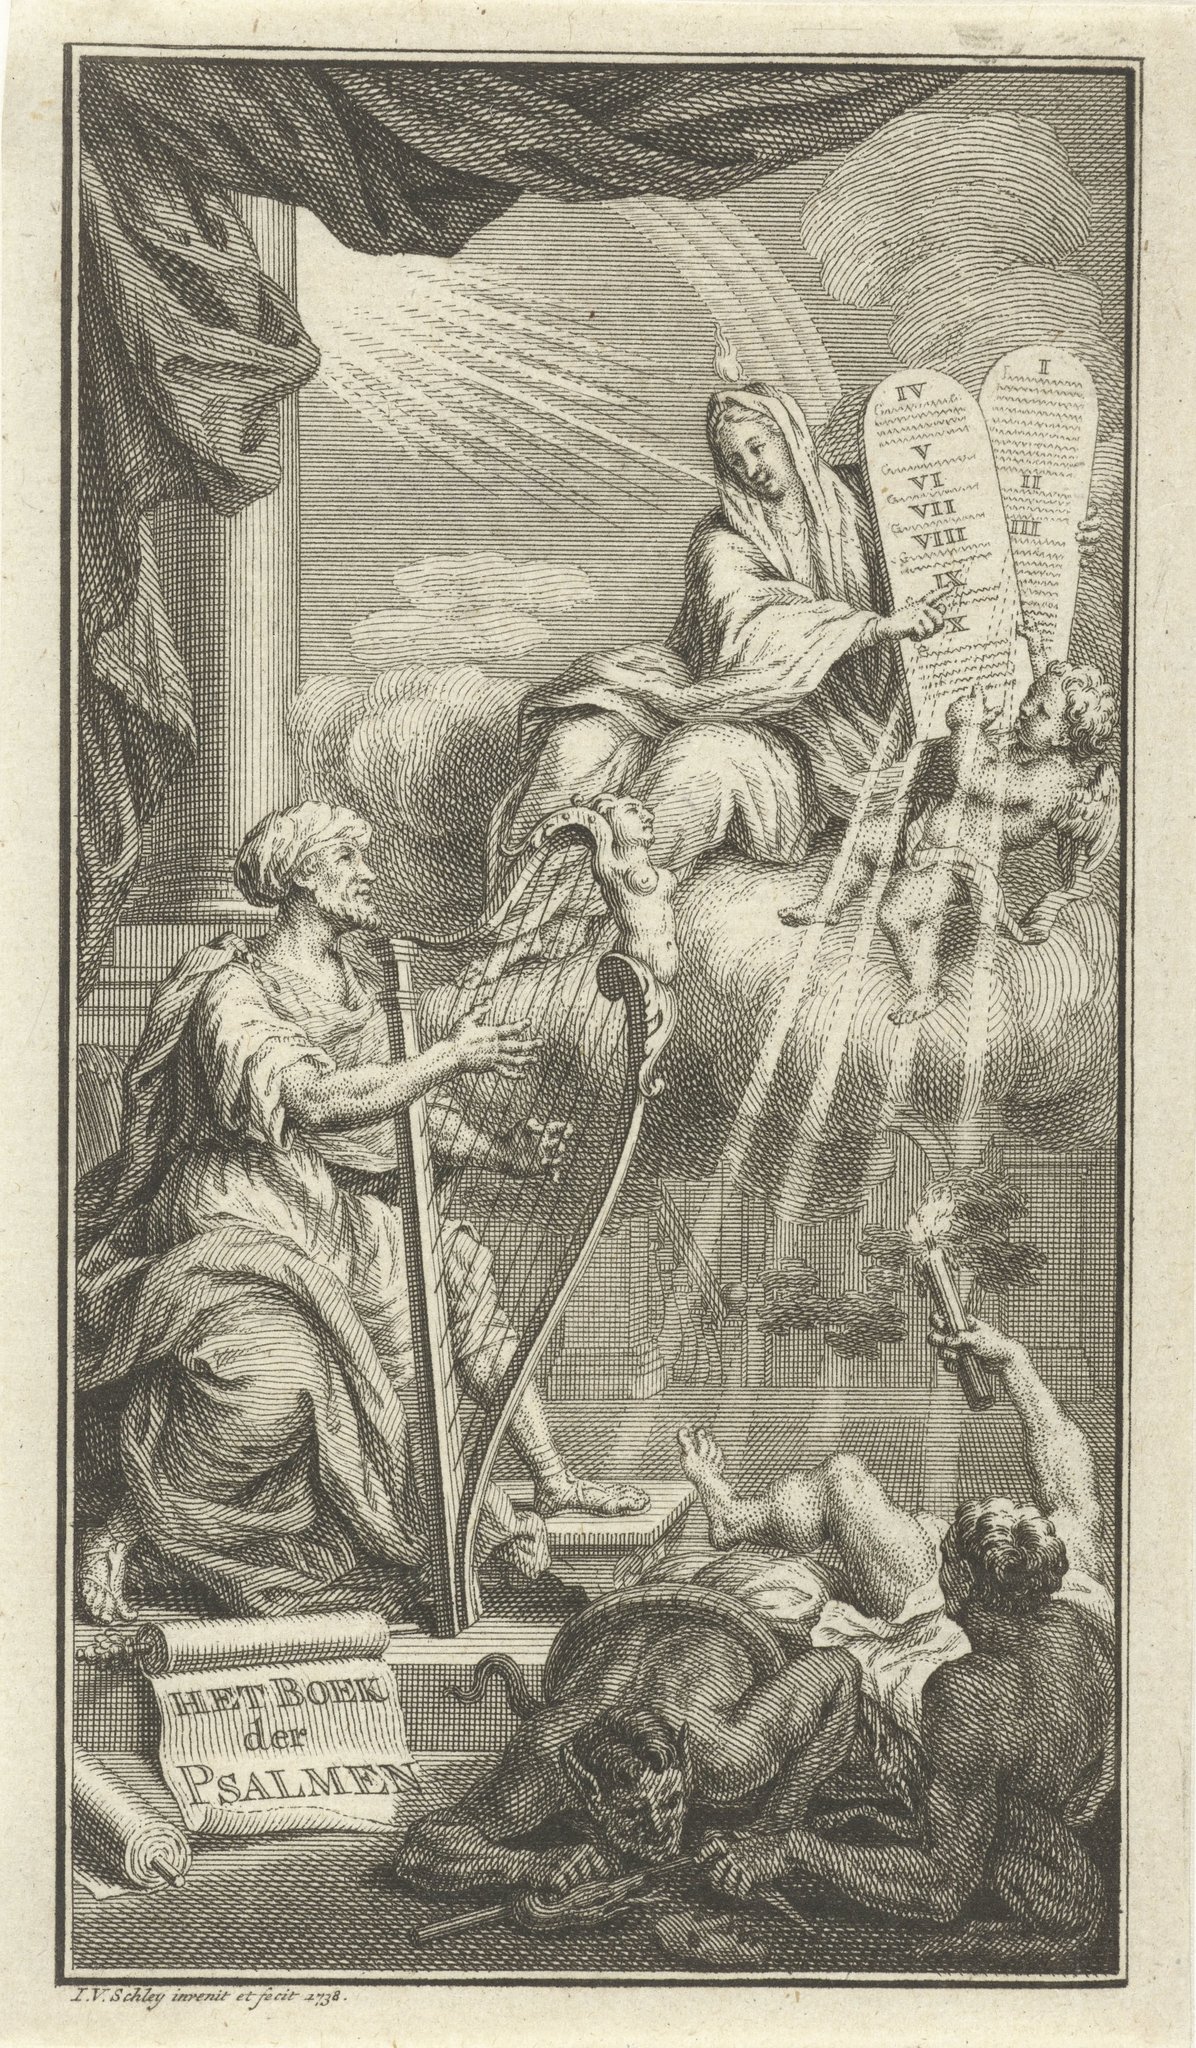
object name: print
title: Titelprent voor, Het Boek der Psalmen, 1738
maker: jacob van der schley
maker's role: draughtsman, print maker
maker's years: 1715-1779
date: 1738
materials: paper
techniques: engraving, etching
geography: amsterdam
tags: the ten commandments represented together, devil(s) and demons, harp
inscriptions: date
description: Titelprent voor "Het Boek der Psalmen". Een man zingt en speelt harp terwijl hij naar de stenen tafelen met de Tien geboden kijkt. Uit de tafelen straalt licht dat duivels en demonen verdrijft.